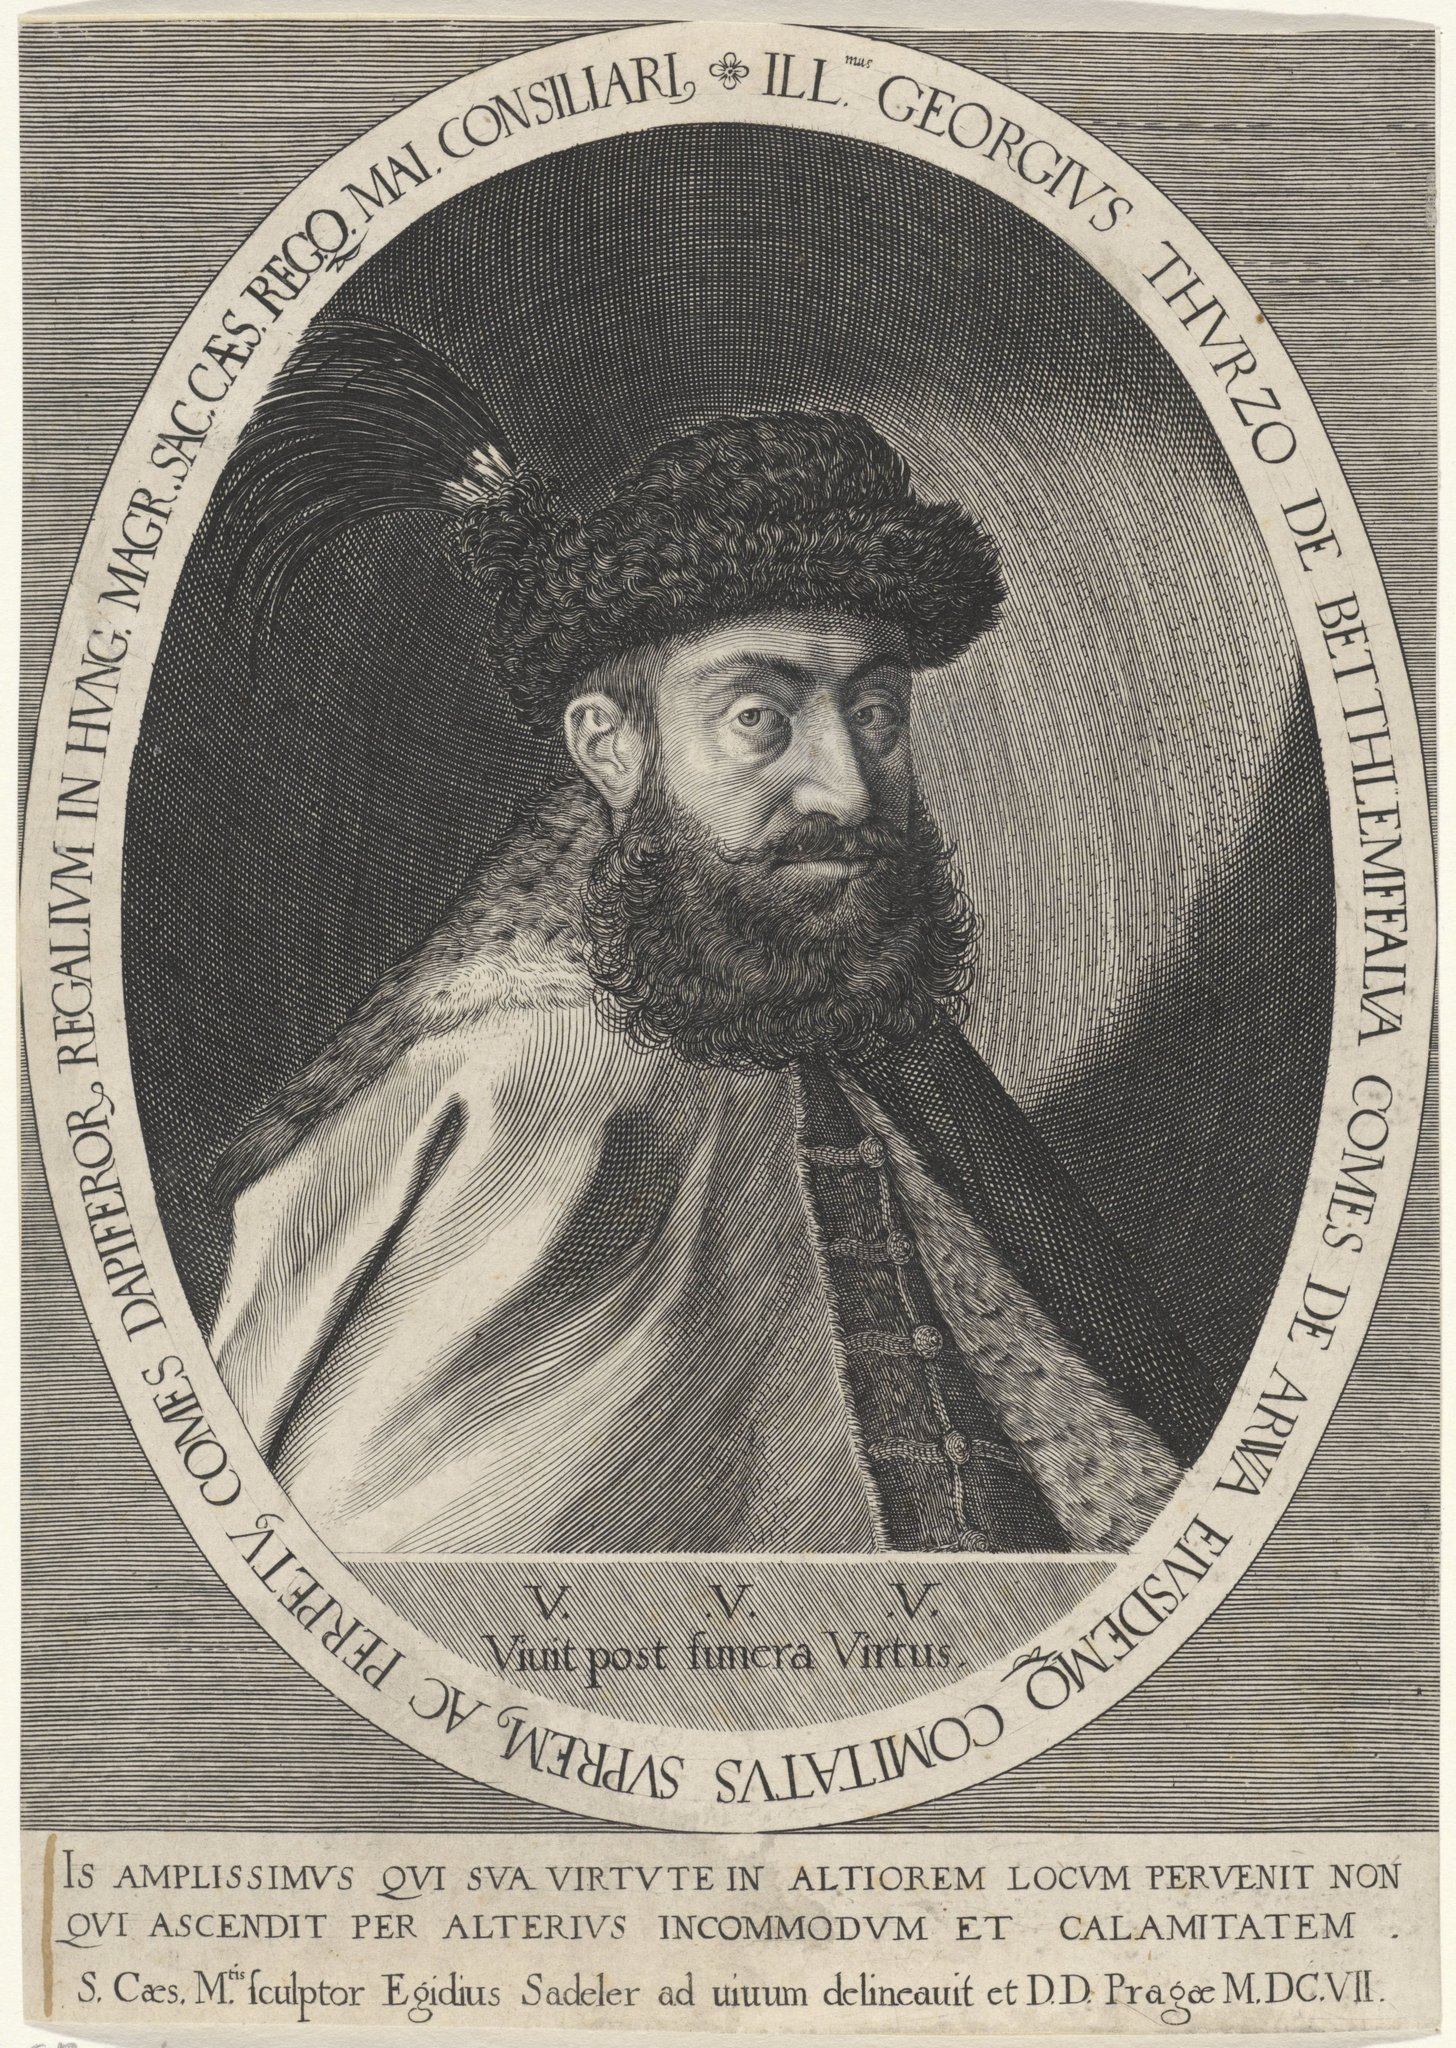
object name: print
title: Portret van Georg III Thurzo von Bethlendorf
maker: aegidius sadeler (ii)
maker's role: draughtsman, print maker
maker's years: 1568-1629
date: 1607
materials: paper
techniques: engraving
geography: prague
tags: earl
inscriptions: collector's mark: Lugt 2228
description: Graaf Georg Thurzo de Bethlenfalvy, lid van het Hongaarse adellijke geslacht Thurzo en onderkoning van Hongarije.